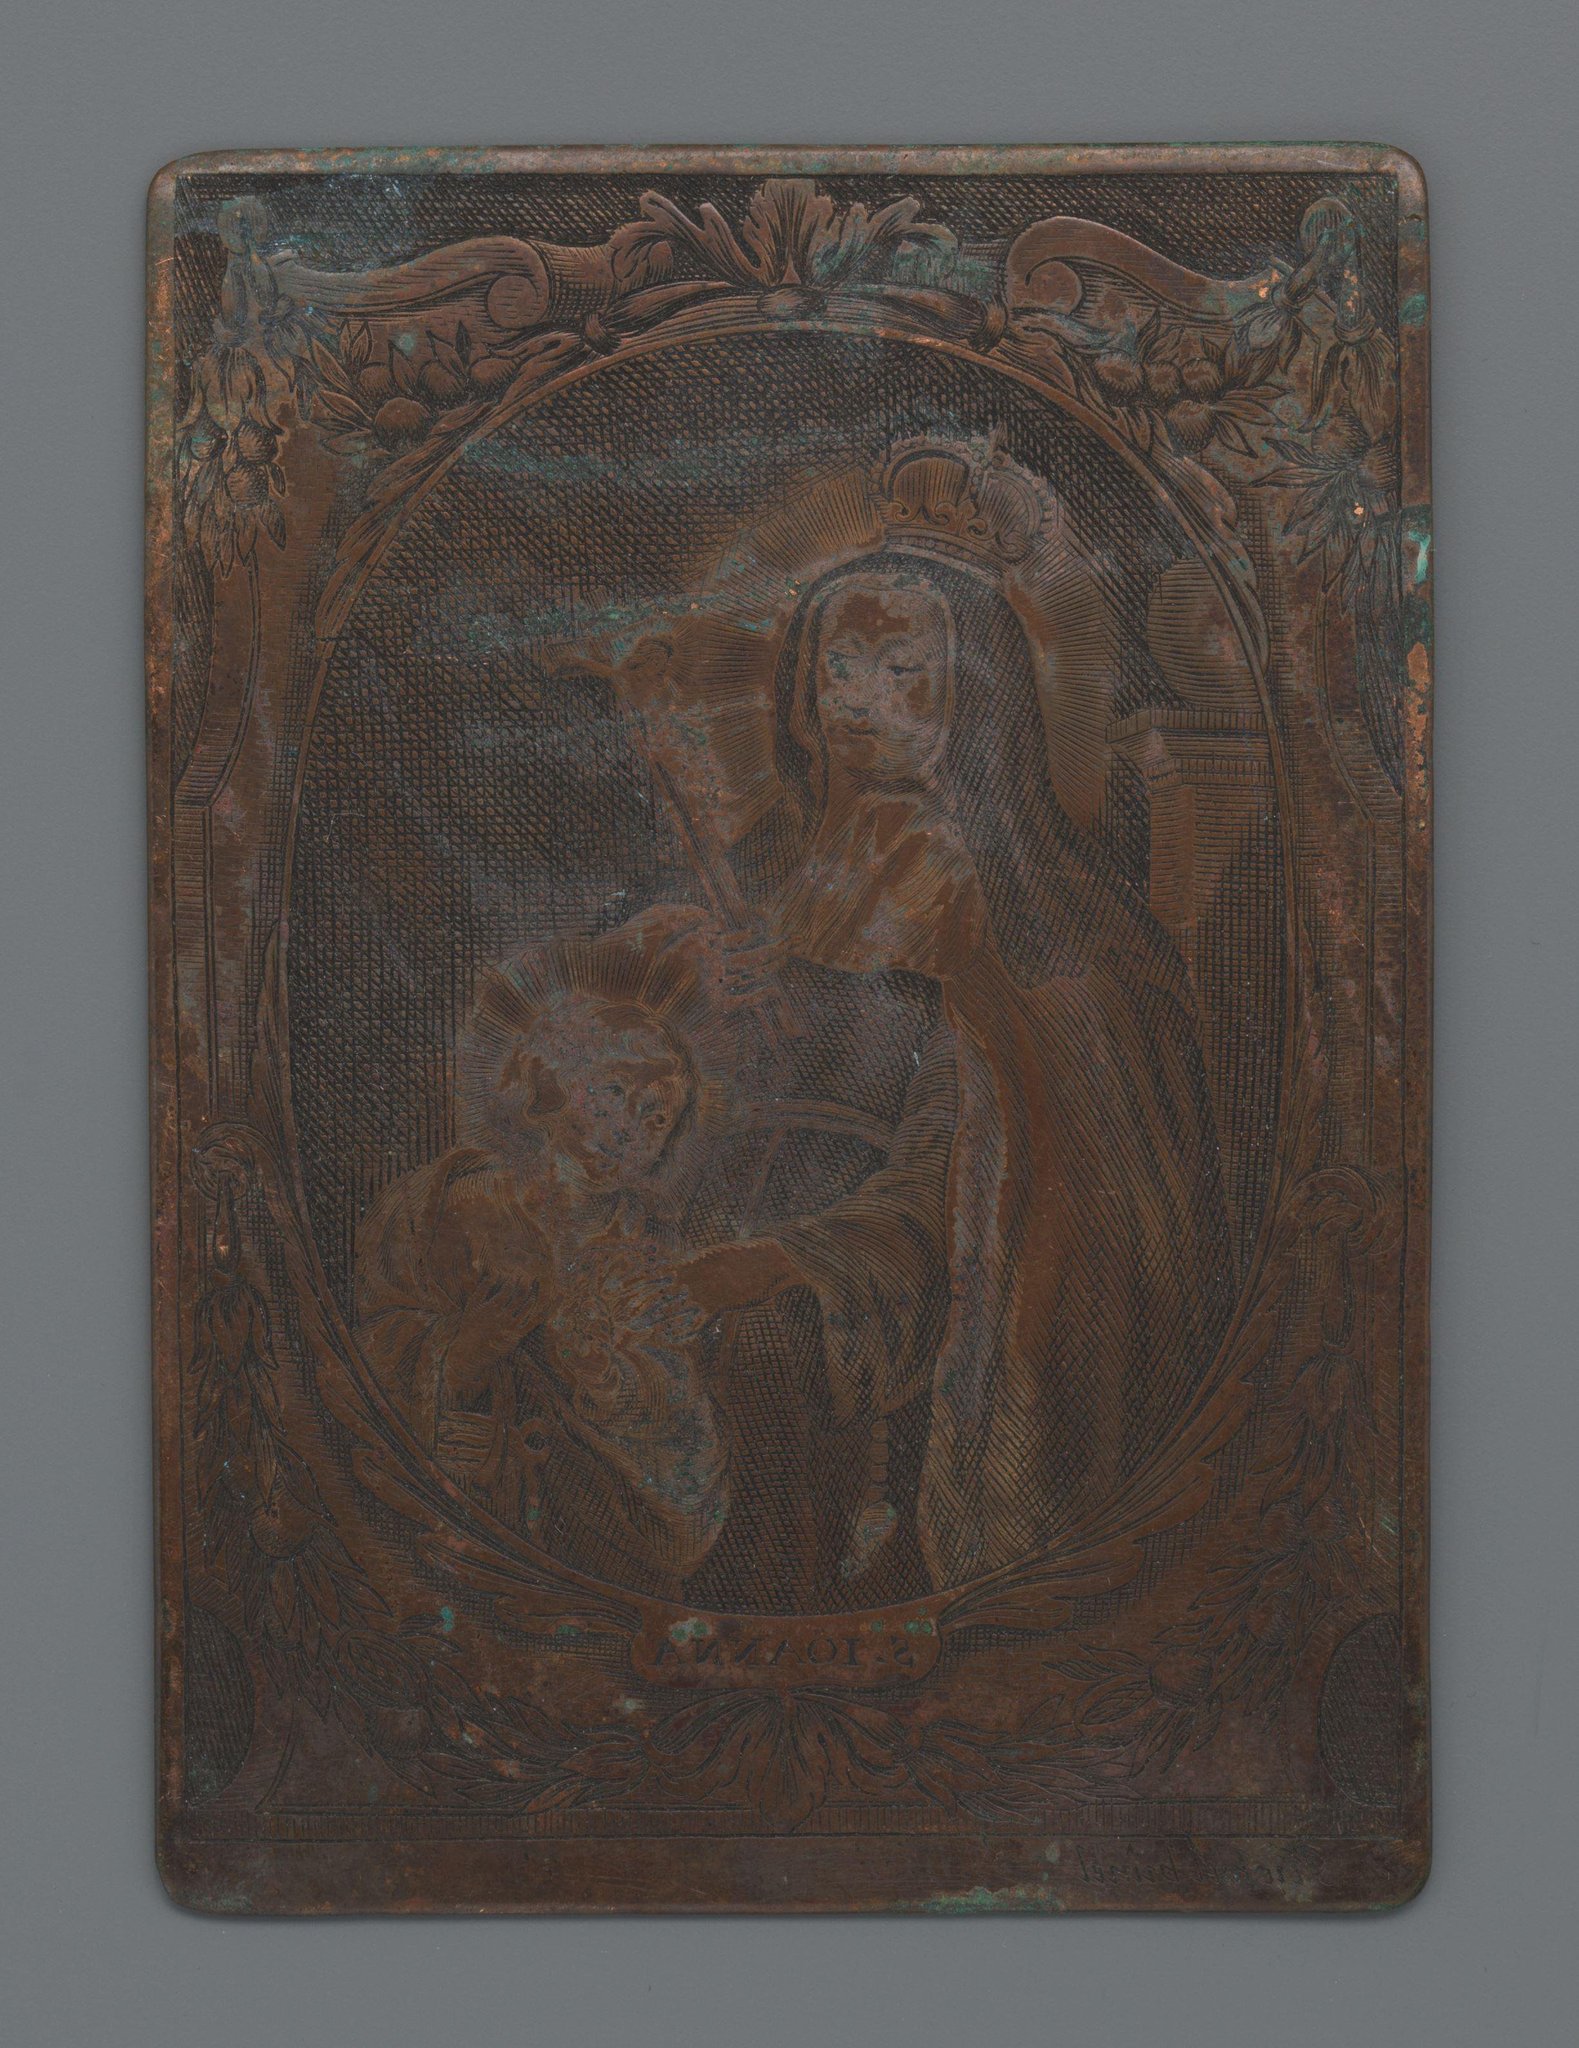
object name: copper plate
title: Koperplaat met de heilige Johanna van Valois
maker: michel bunel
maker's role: print maker, publisher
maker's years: 1670-1739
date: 1650-1700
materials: copper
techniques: engraving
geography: antwerp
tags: mystic marriage, female saints (with name)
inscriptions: signature: ‘Michel Bunel’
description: De platen (RP-D-2014-9-1 t/m 35) zijn vrijwel allemaal vervaardigd door anonieme graveurs werkend voor de Antwerpse uitgevers Cornelis Galle, Frans Huberti (Huybrechts), Theodor van Merlen II en Michel Bunel. Vermoedelijk zijn ze uiteindelijk beland in één fonds, wellicht dat van Michel Bunel (1670-1739) en warden sindsdien bij elkaar bewaard. Afwijkend is de grote prent van Henry Verbruggen met een weergave van de Preekstoel uit de St. Gudule-kerk te Brussel. Twee prenten zijn verpakt in een oude afdruk van de prent, zoals te doen gebruikelijk in uitgeverijen (vergl. oude platen in Museum Plantijn Moretus, Antwerpen). Van 8 platen heeft de vorige eigenaar afdrukken laten maken op modern papier.